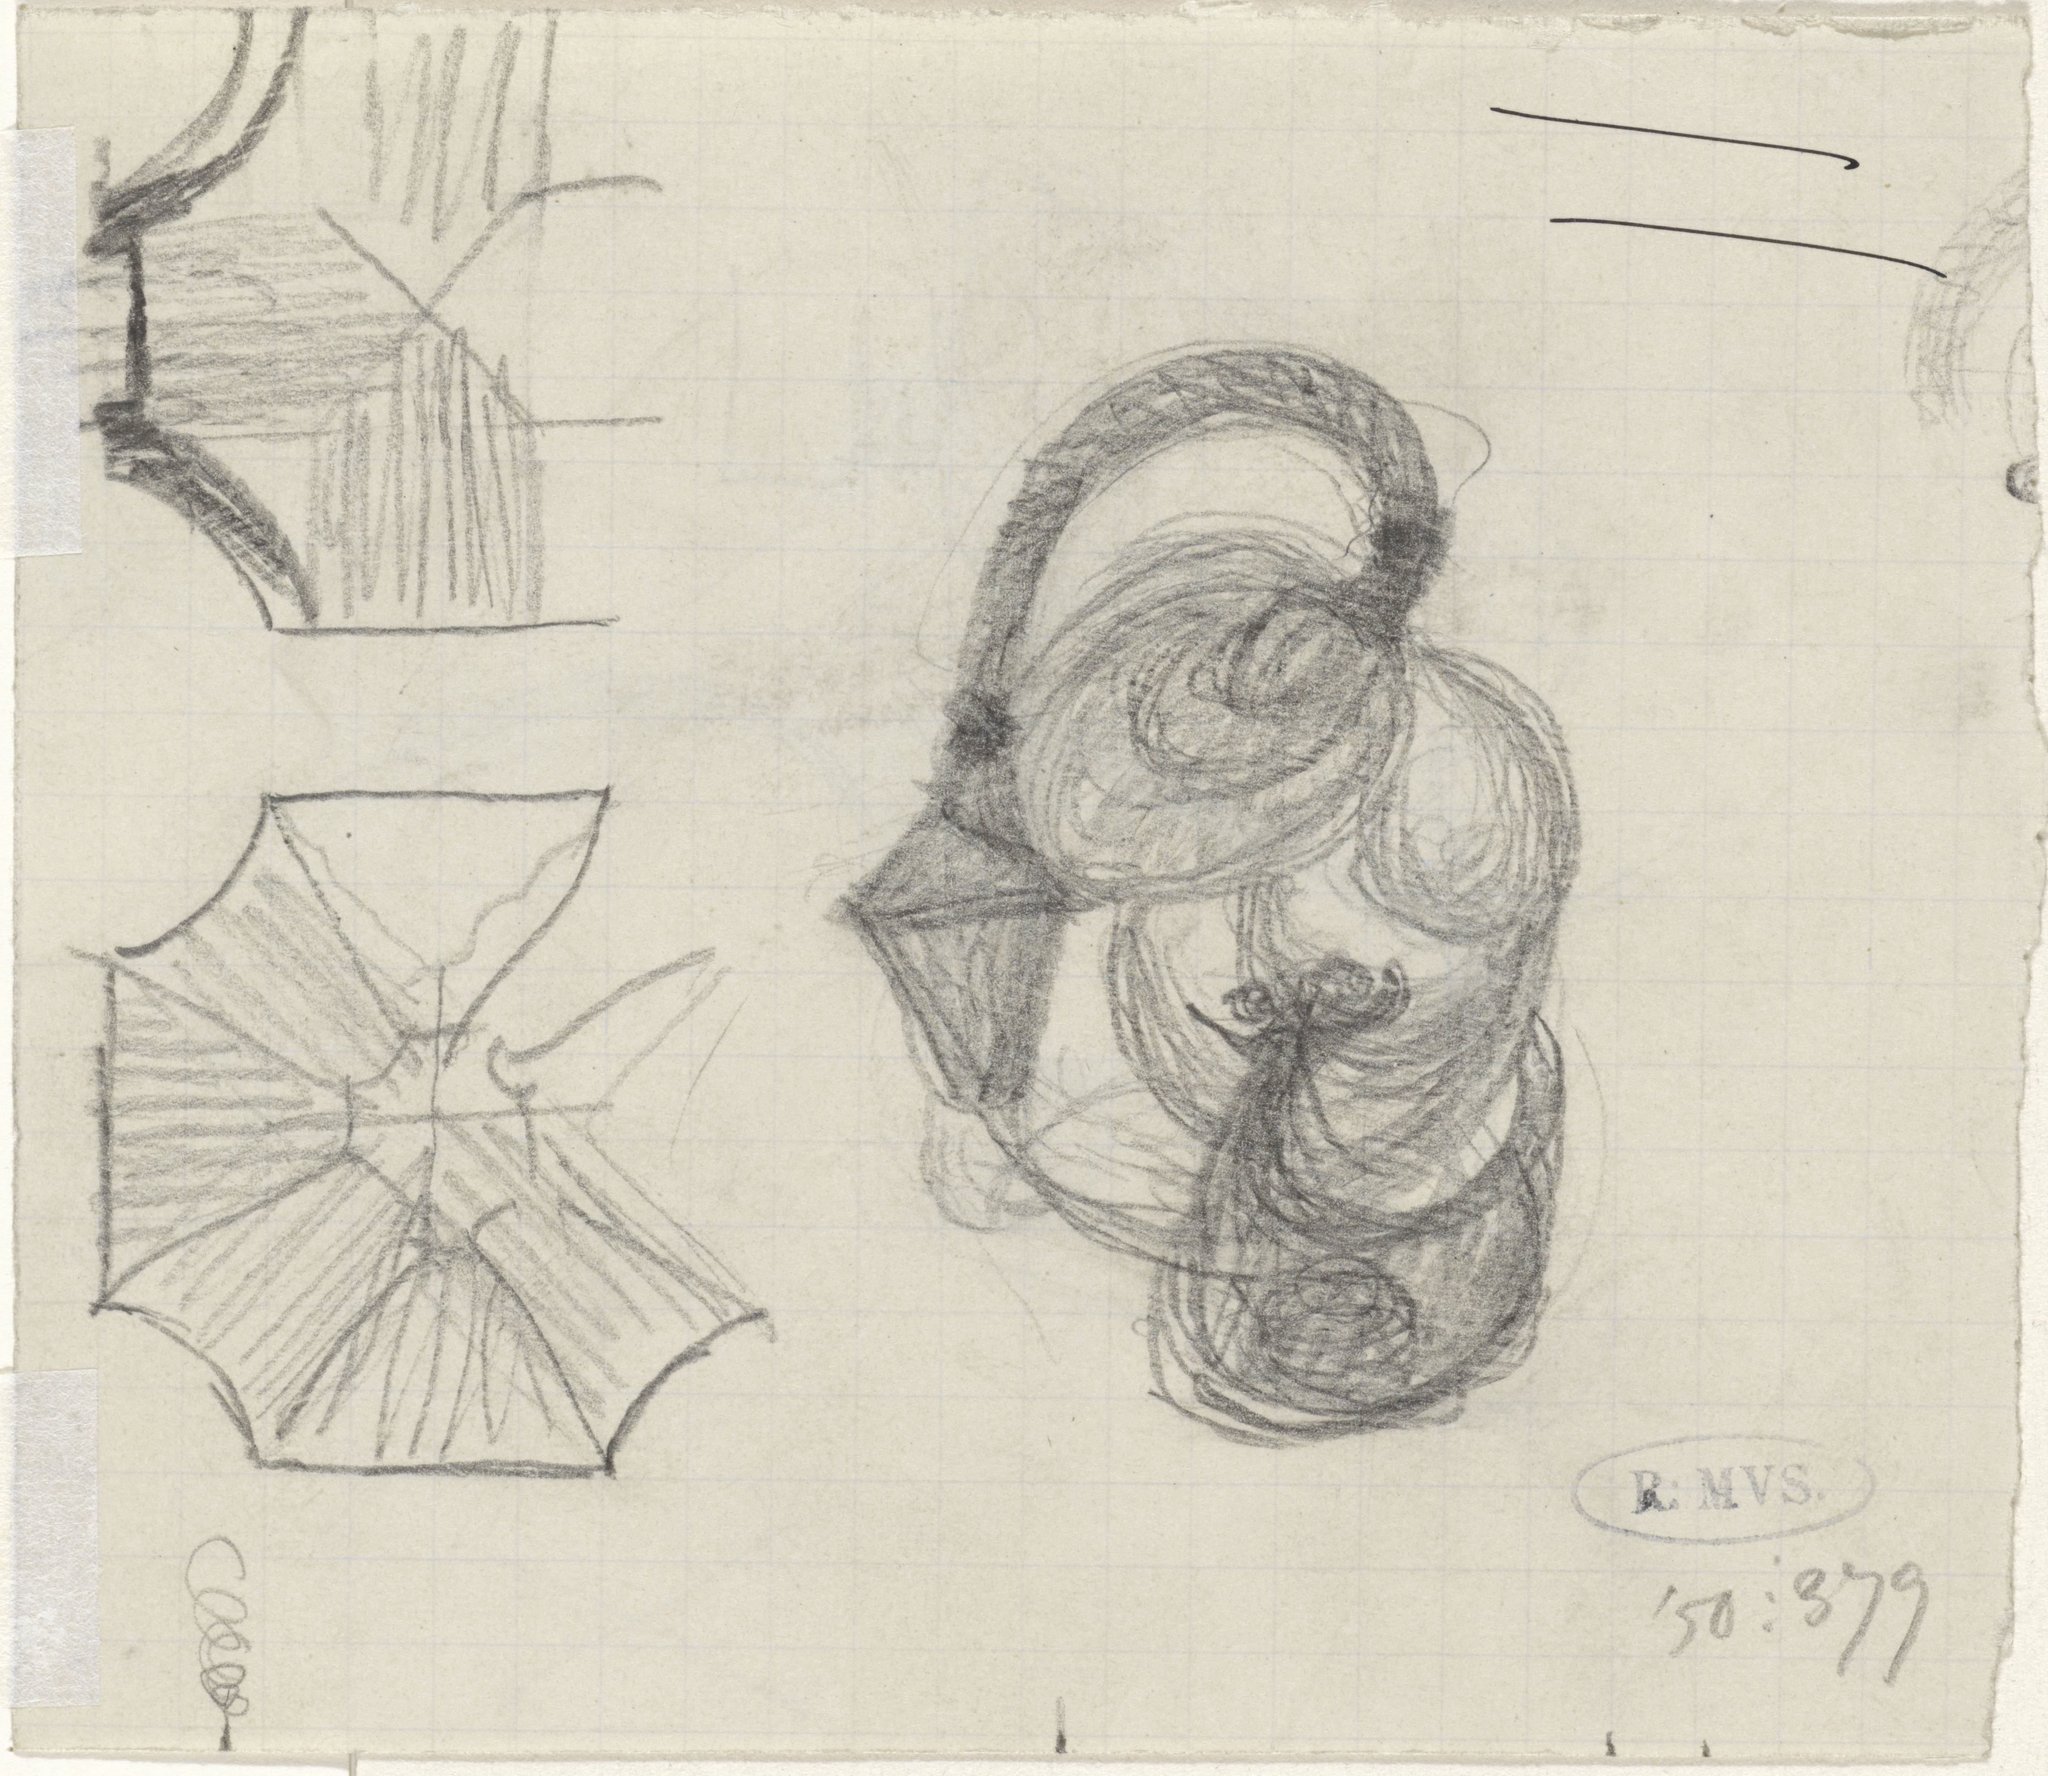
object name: design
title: Ontwerpen voor een sieraad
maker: mathieu lauweriks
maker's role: designer, draughtsman, print maker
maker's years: 1864-1932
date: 1874-1932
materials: pencil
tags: ornaments, jewels